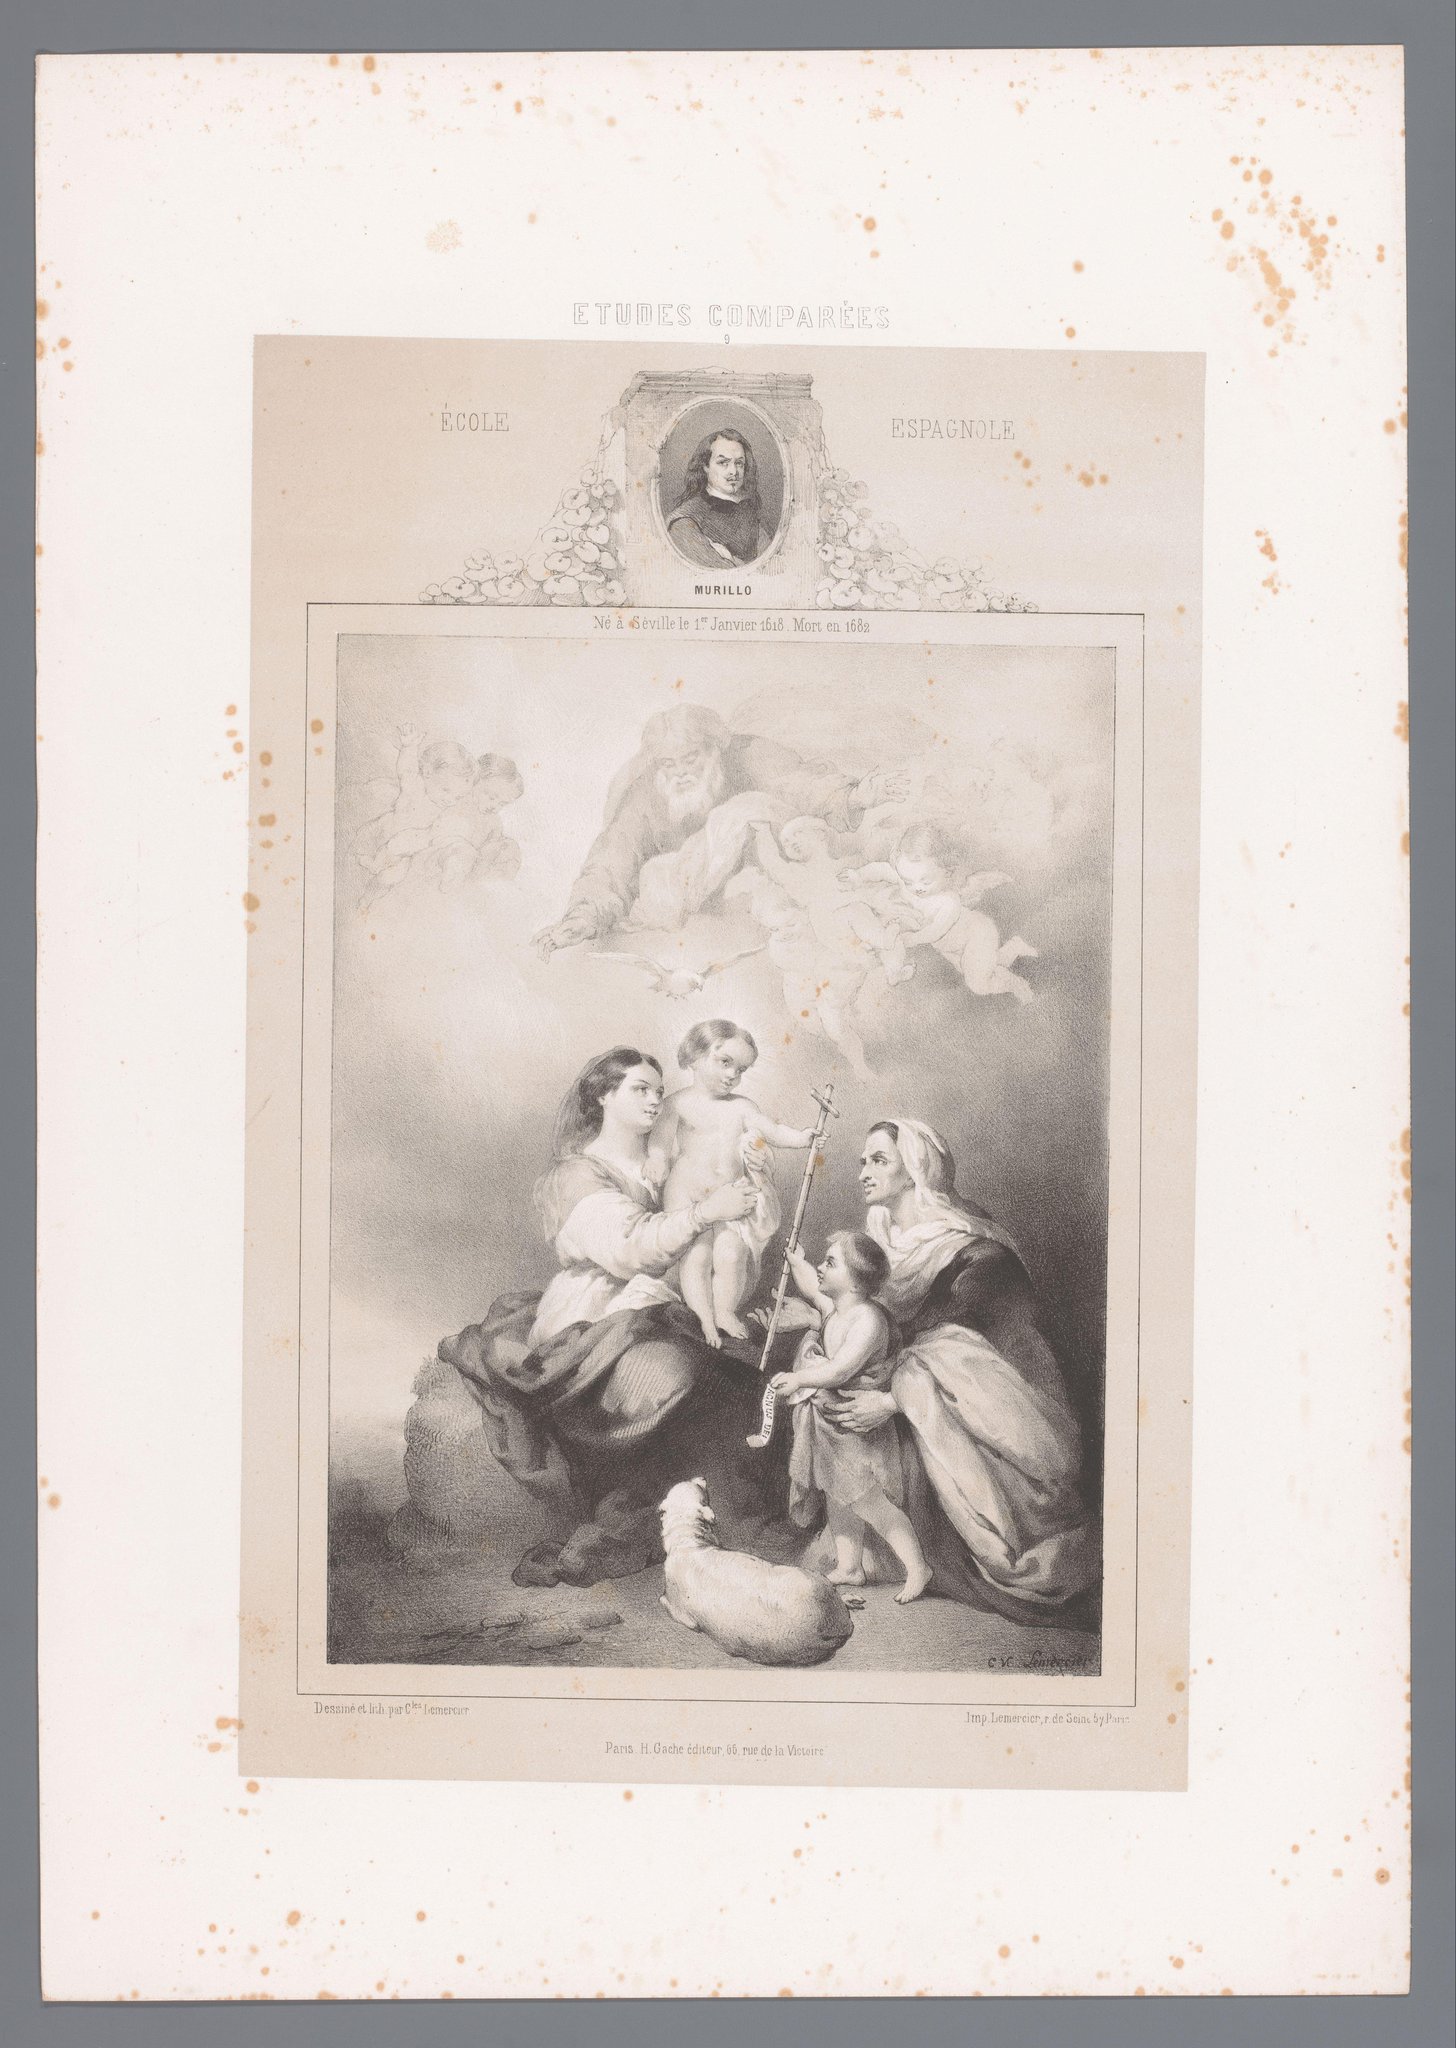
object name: print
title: Studies ter vergelijking van meesters uit verschillende schilderscholen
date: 1850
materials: paper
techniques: tone lithography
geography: paris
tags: sevilla, draughtsman, bartolomé esteban murillo, historical persons, painting (including book-illumination, miniature-painting)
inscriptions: collector's mark: Lugt 2228a